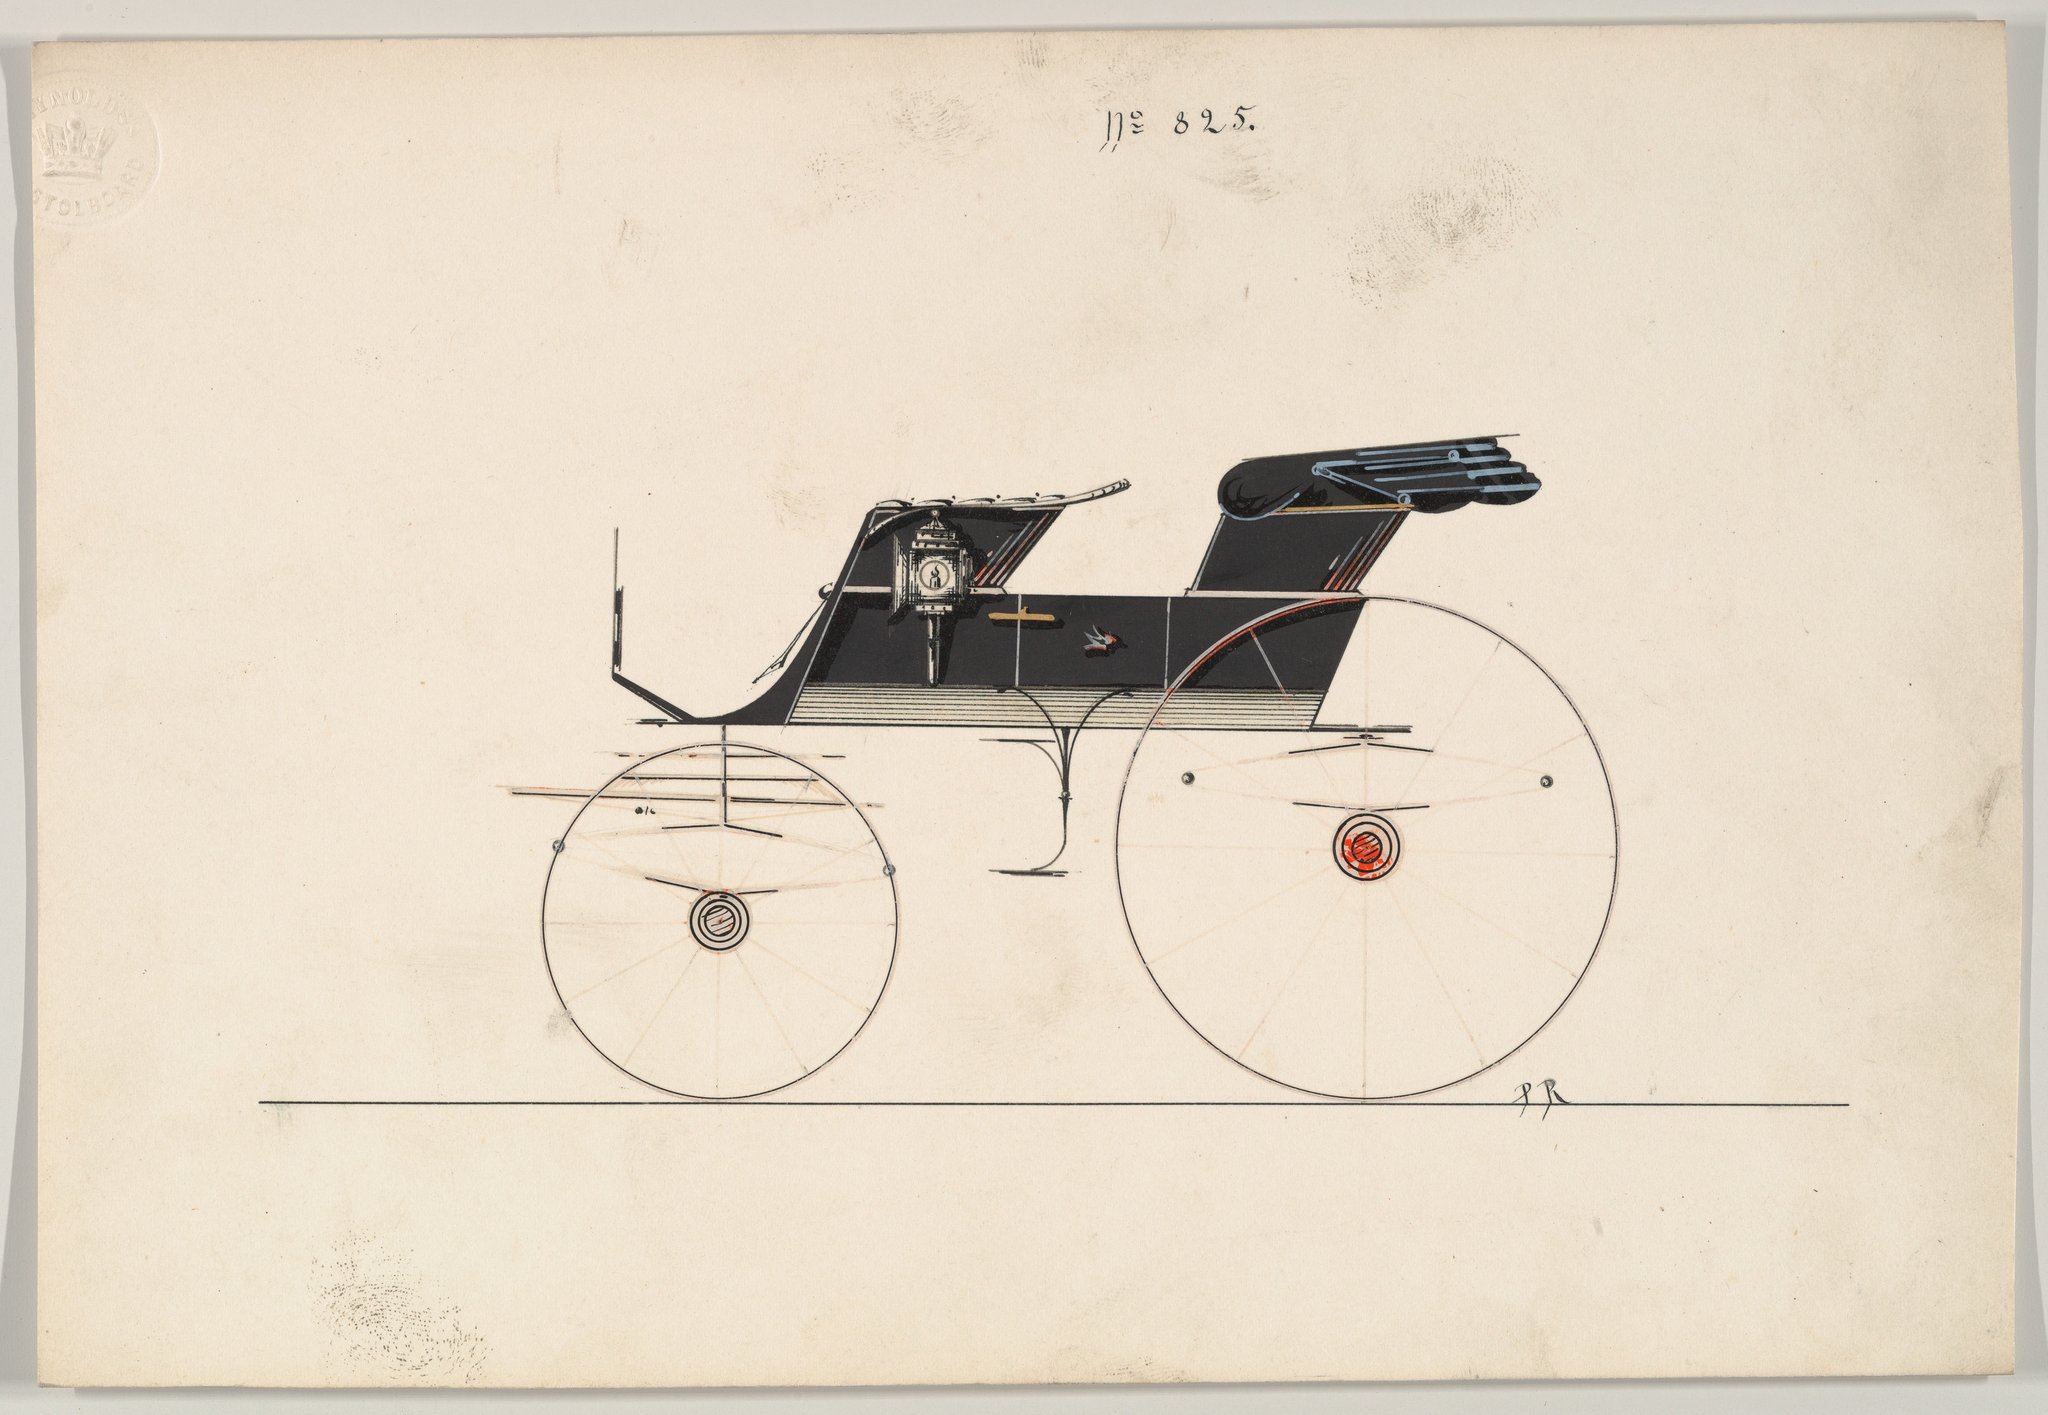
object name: drawing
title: Design for Phaeton, no. 825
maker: brewster & co.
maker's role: manufacturer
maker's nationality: american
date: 1850-1874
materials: gouache, ink, watercolor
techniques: pen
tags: carriages